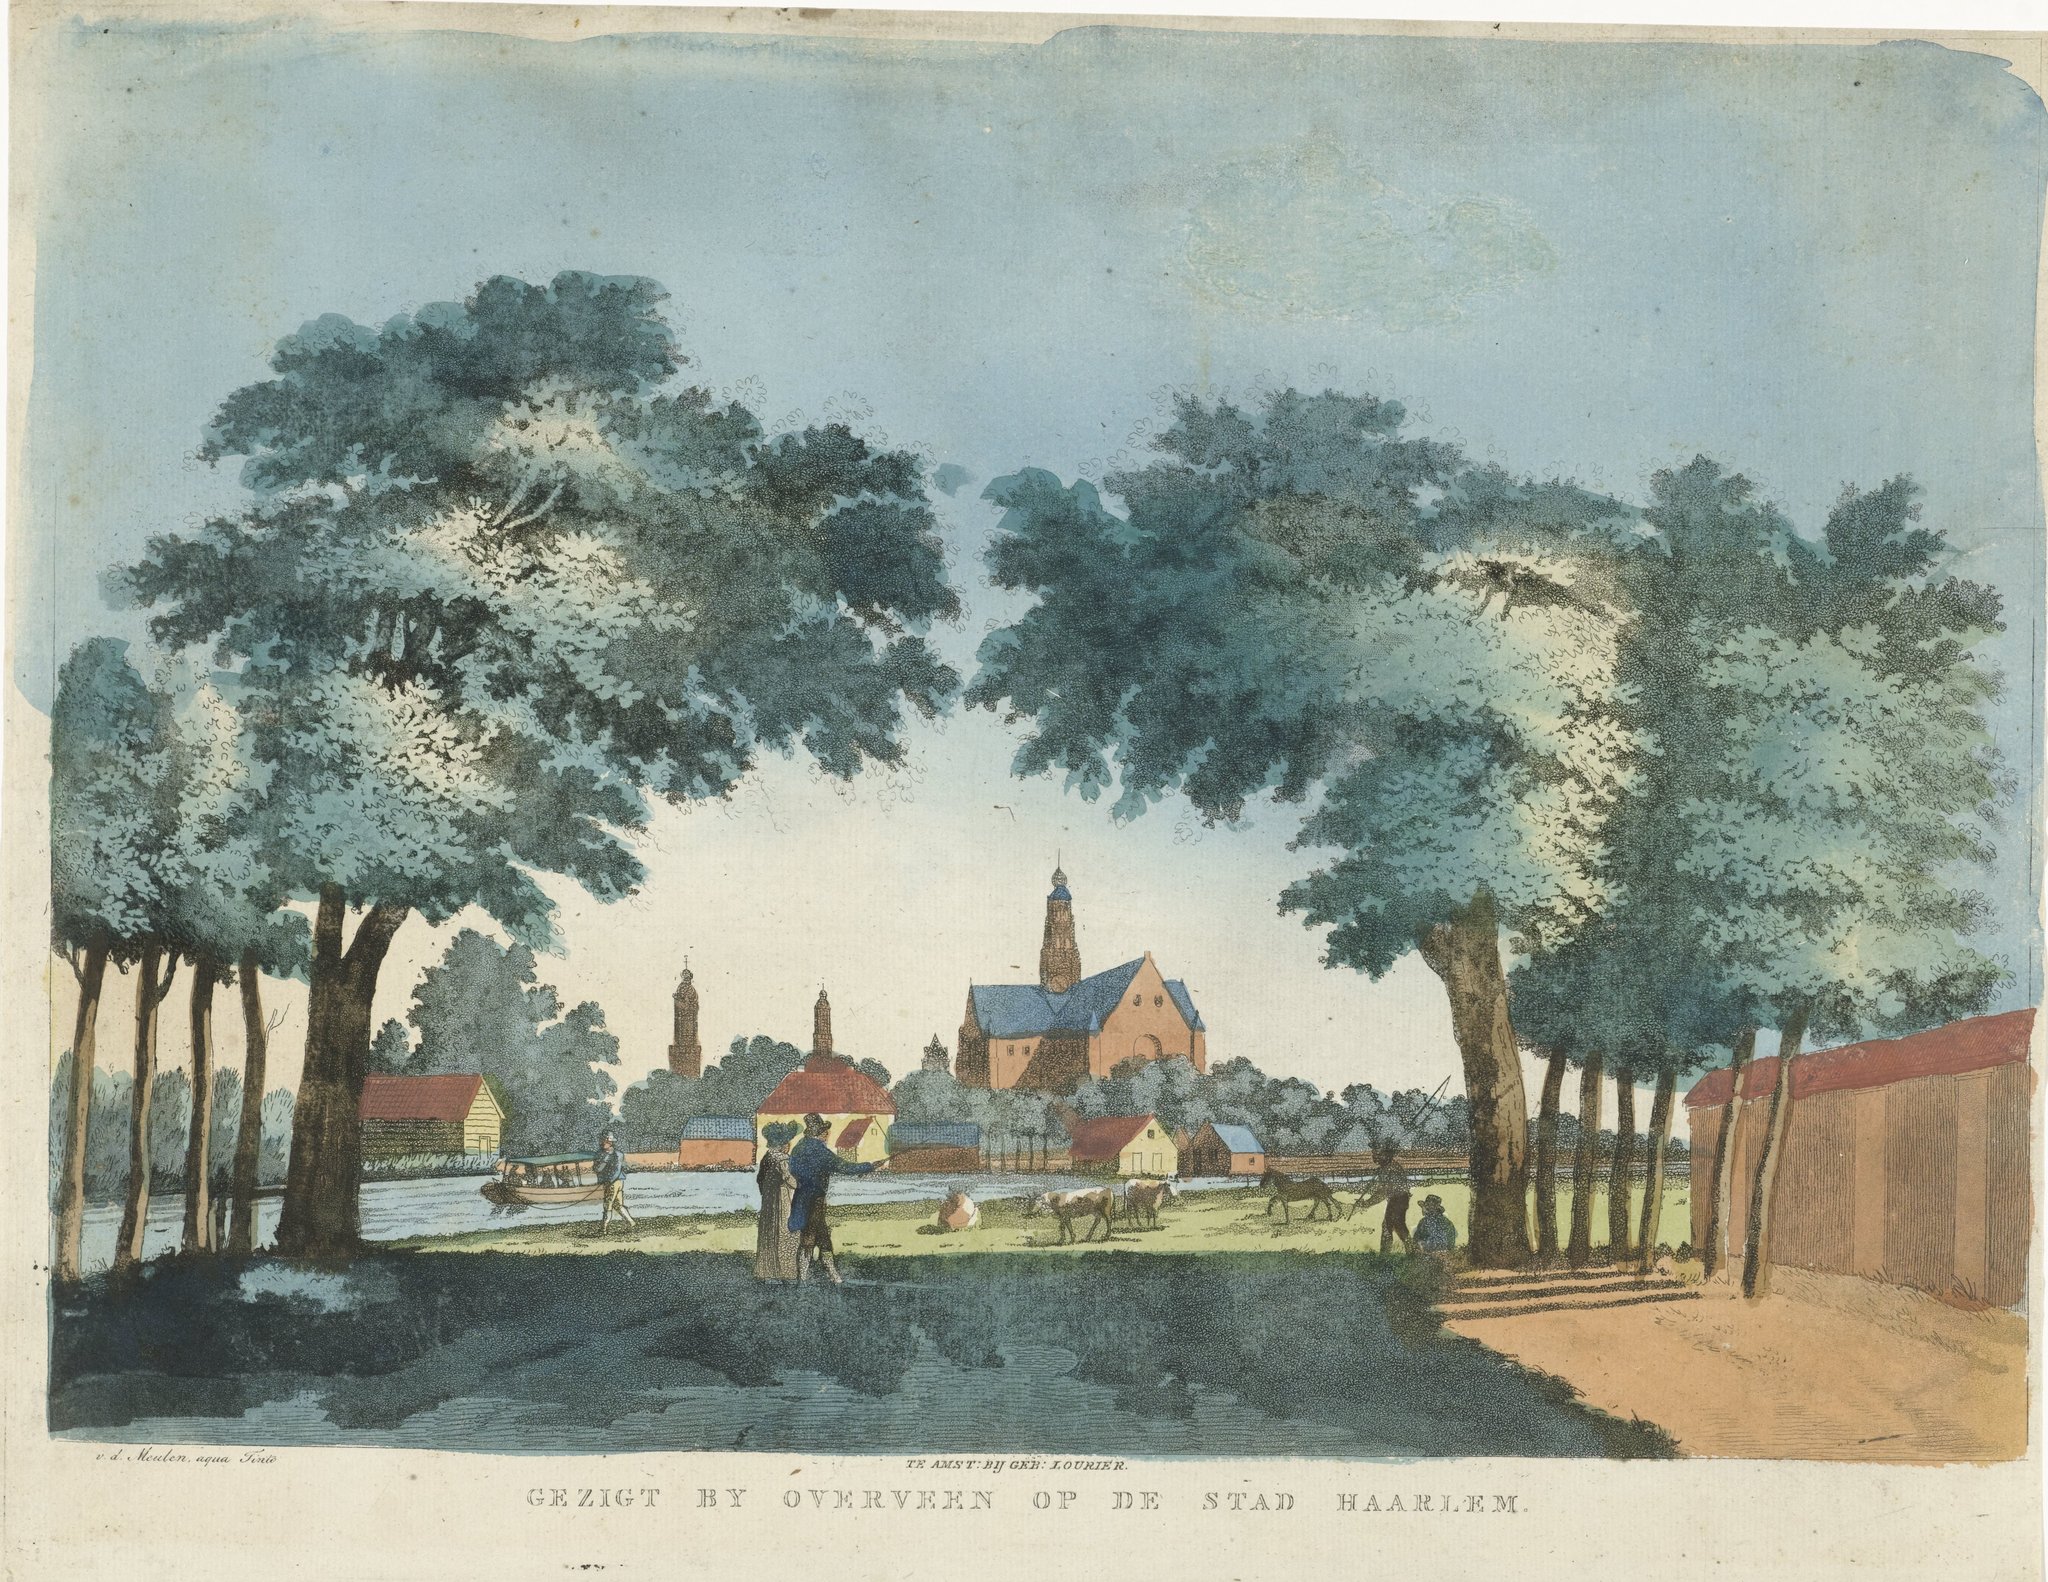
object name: print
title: Gezigt by Overveen op de stad Haarlem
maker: pieter van der meulen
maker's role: draughtsman, painter, print maker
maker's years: 1780-1858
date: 1790-1858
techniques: aquatint, etching, hand coloring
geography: amsterdam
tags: city-view, and landscape with man-made constructions, haarlem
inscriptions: collector's mark: Lugt 2228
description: Gezicht op Haarlem vanuit Overveen. Op de voorgrond een gearmd paar, koeien en twee mannen onder een boom. Op de vaart een passagiersboot.